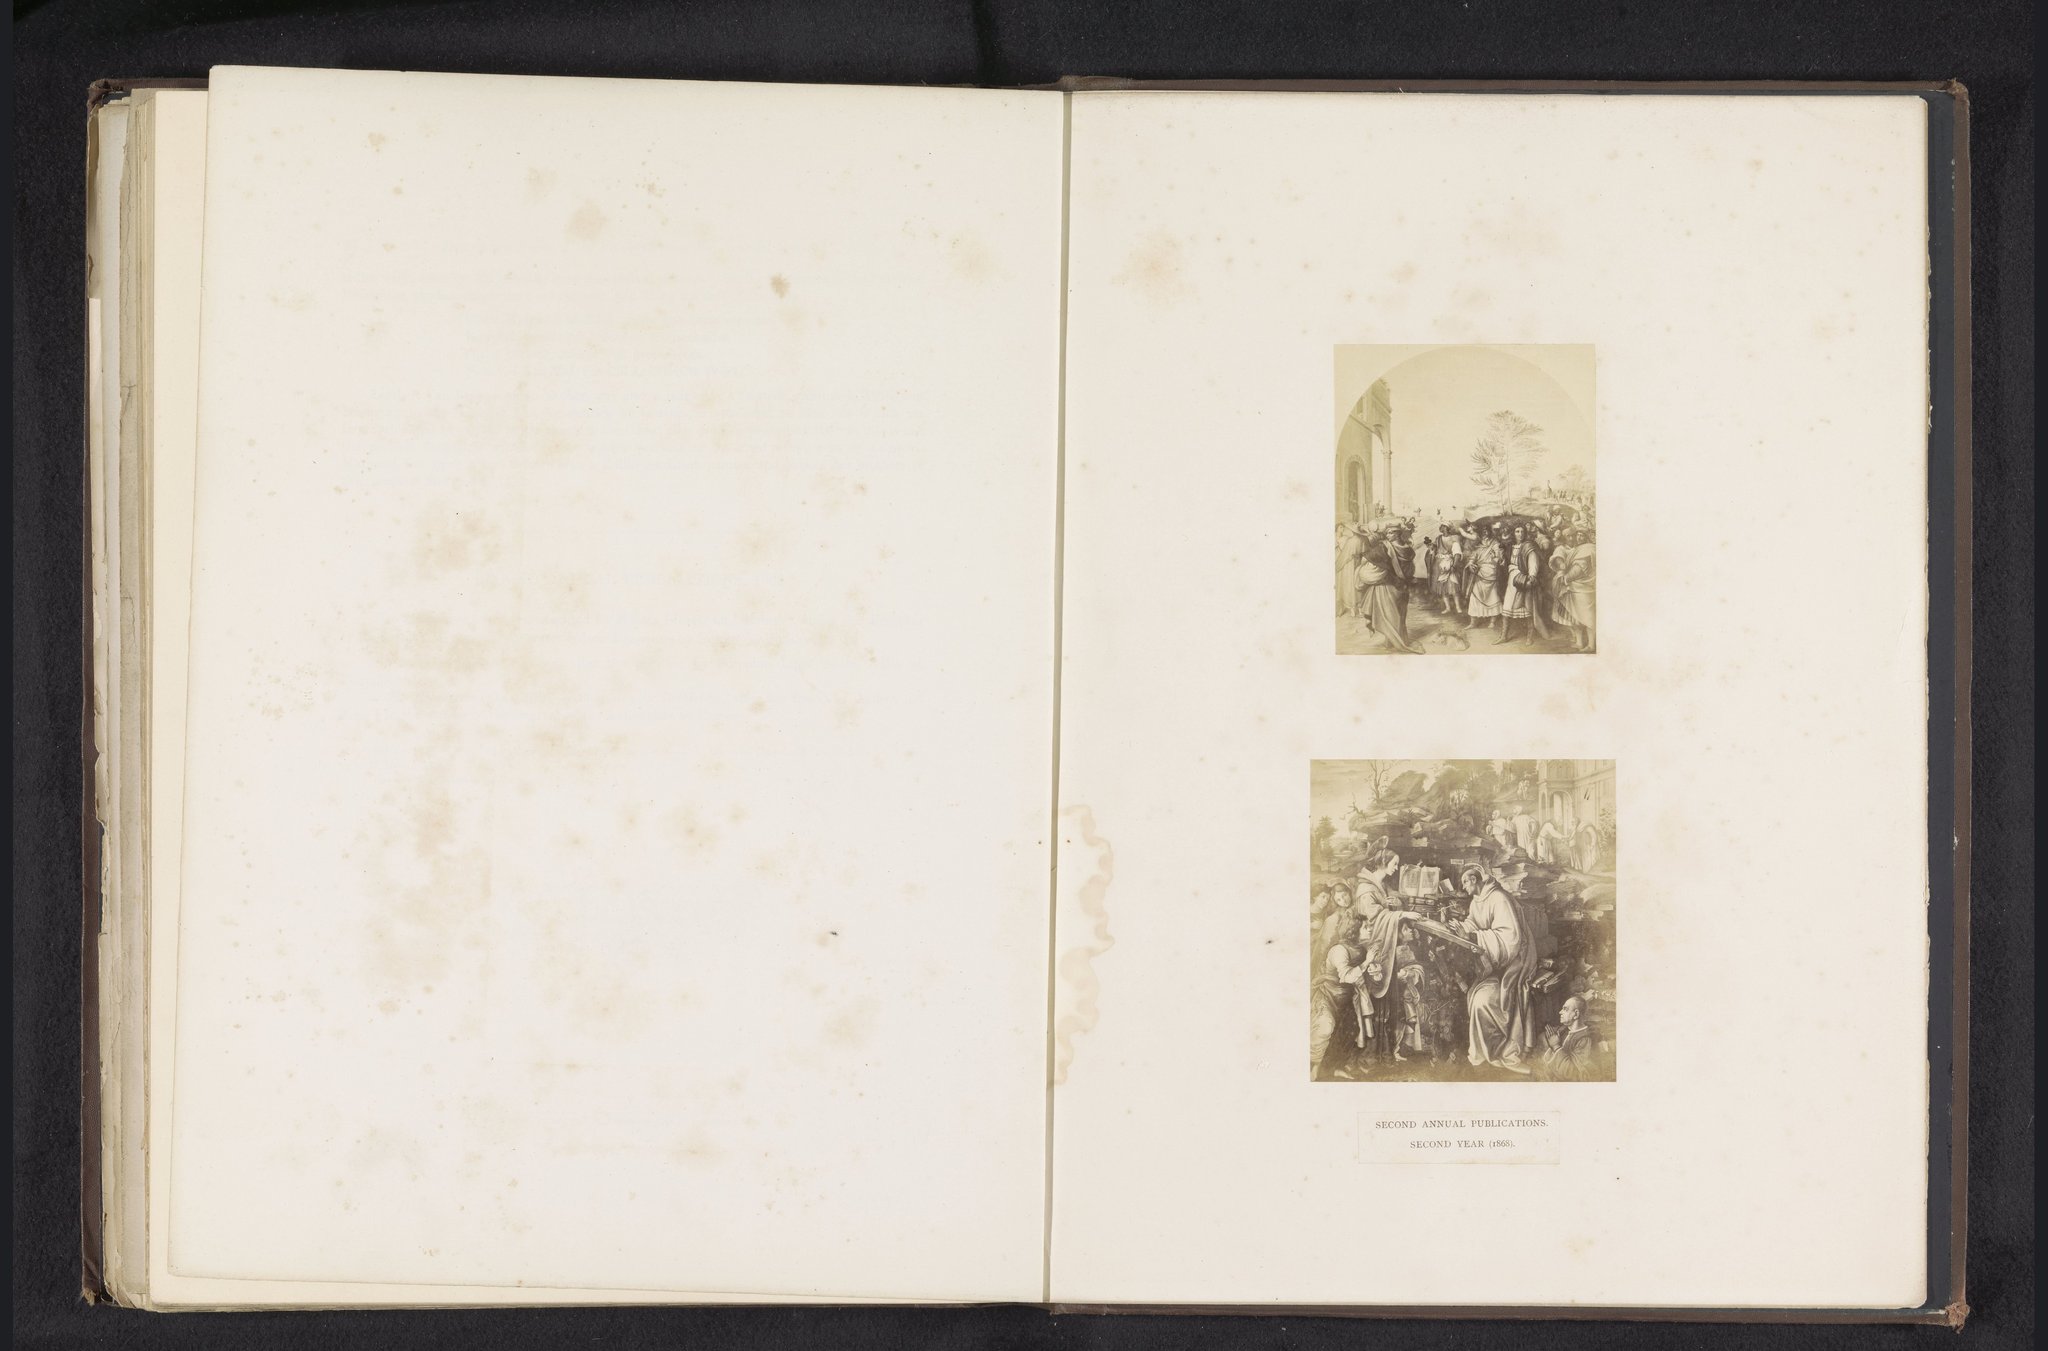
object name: photograph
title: Twee fotoreproducties van een publicatie door de Arundel Society met een schilderij van Filippino Lippi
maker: Anonymous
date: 1859-1869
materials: photographic support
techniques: albumen print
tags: book, painting (including book-illumination, miniature-painting)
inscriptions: inscription: ‘second annual publications. second year (1868).’